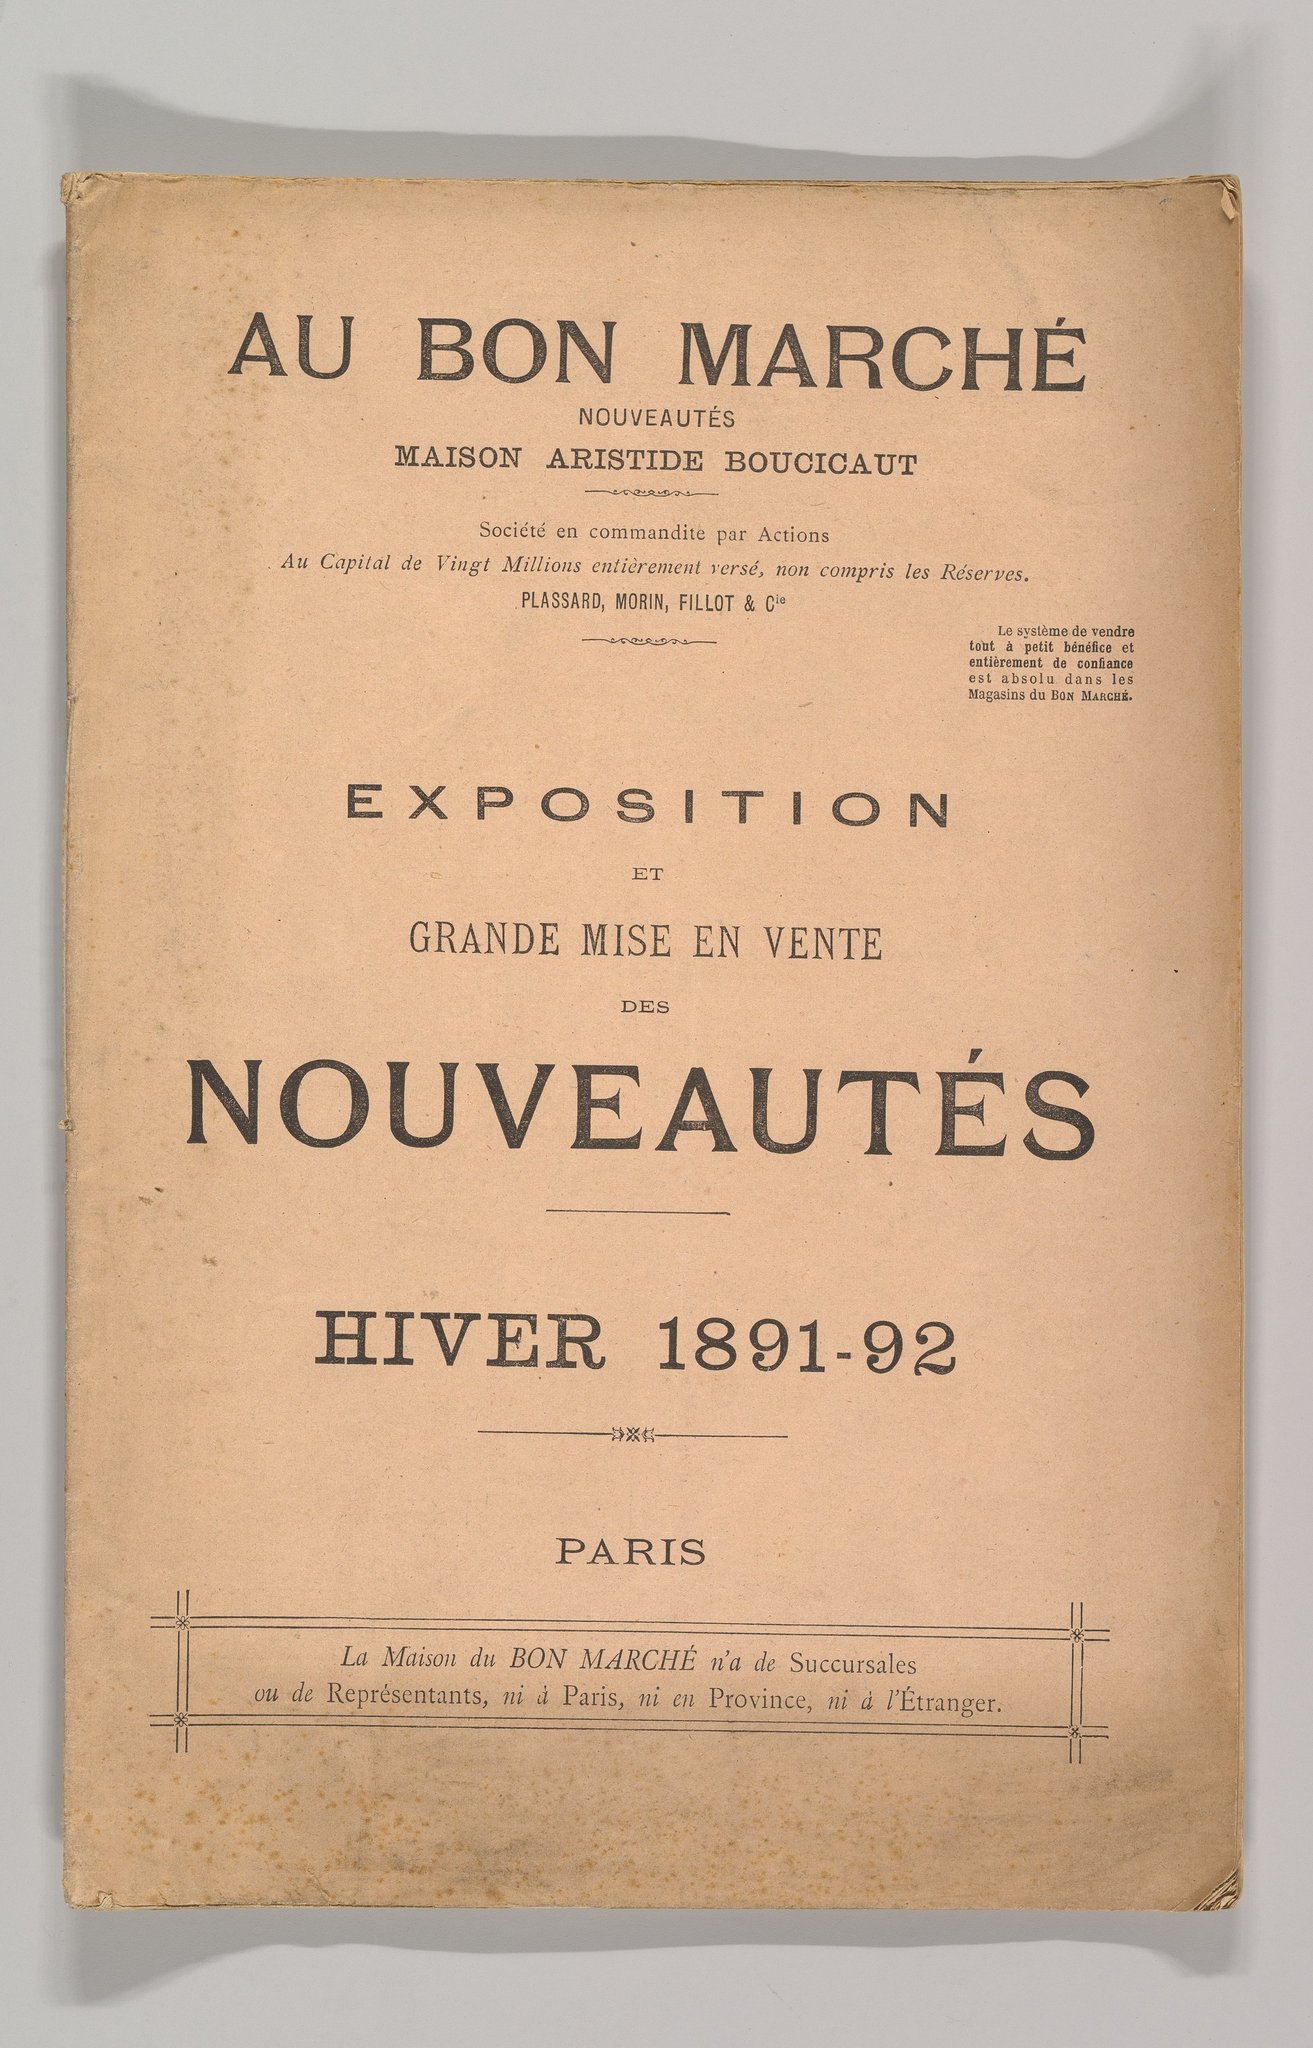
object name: book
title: Au Bon Marché-Exposition et Grande Misé en Vente des Nouveautés Hiver 1891–92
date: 1891-1892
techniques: engraving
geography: france